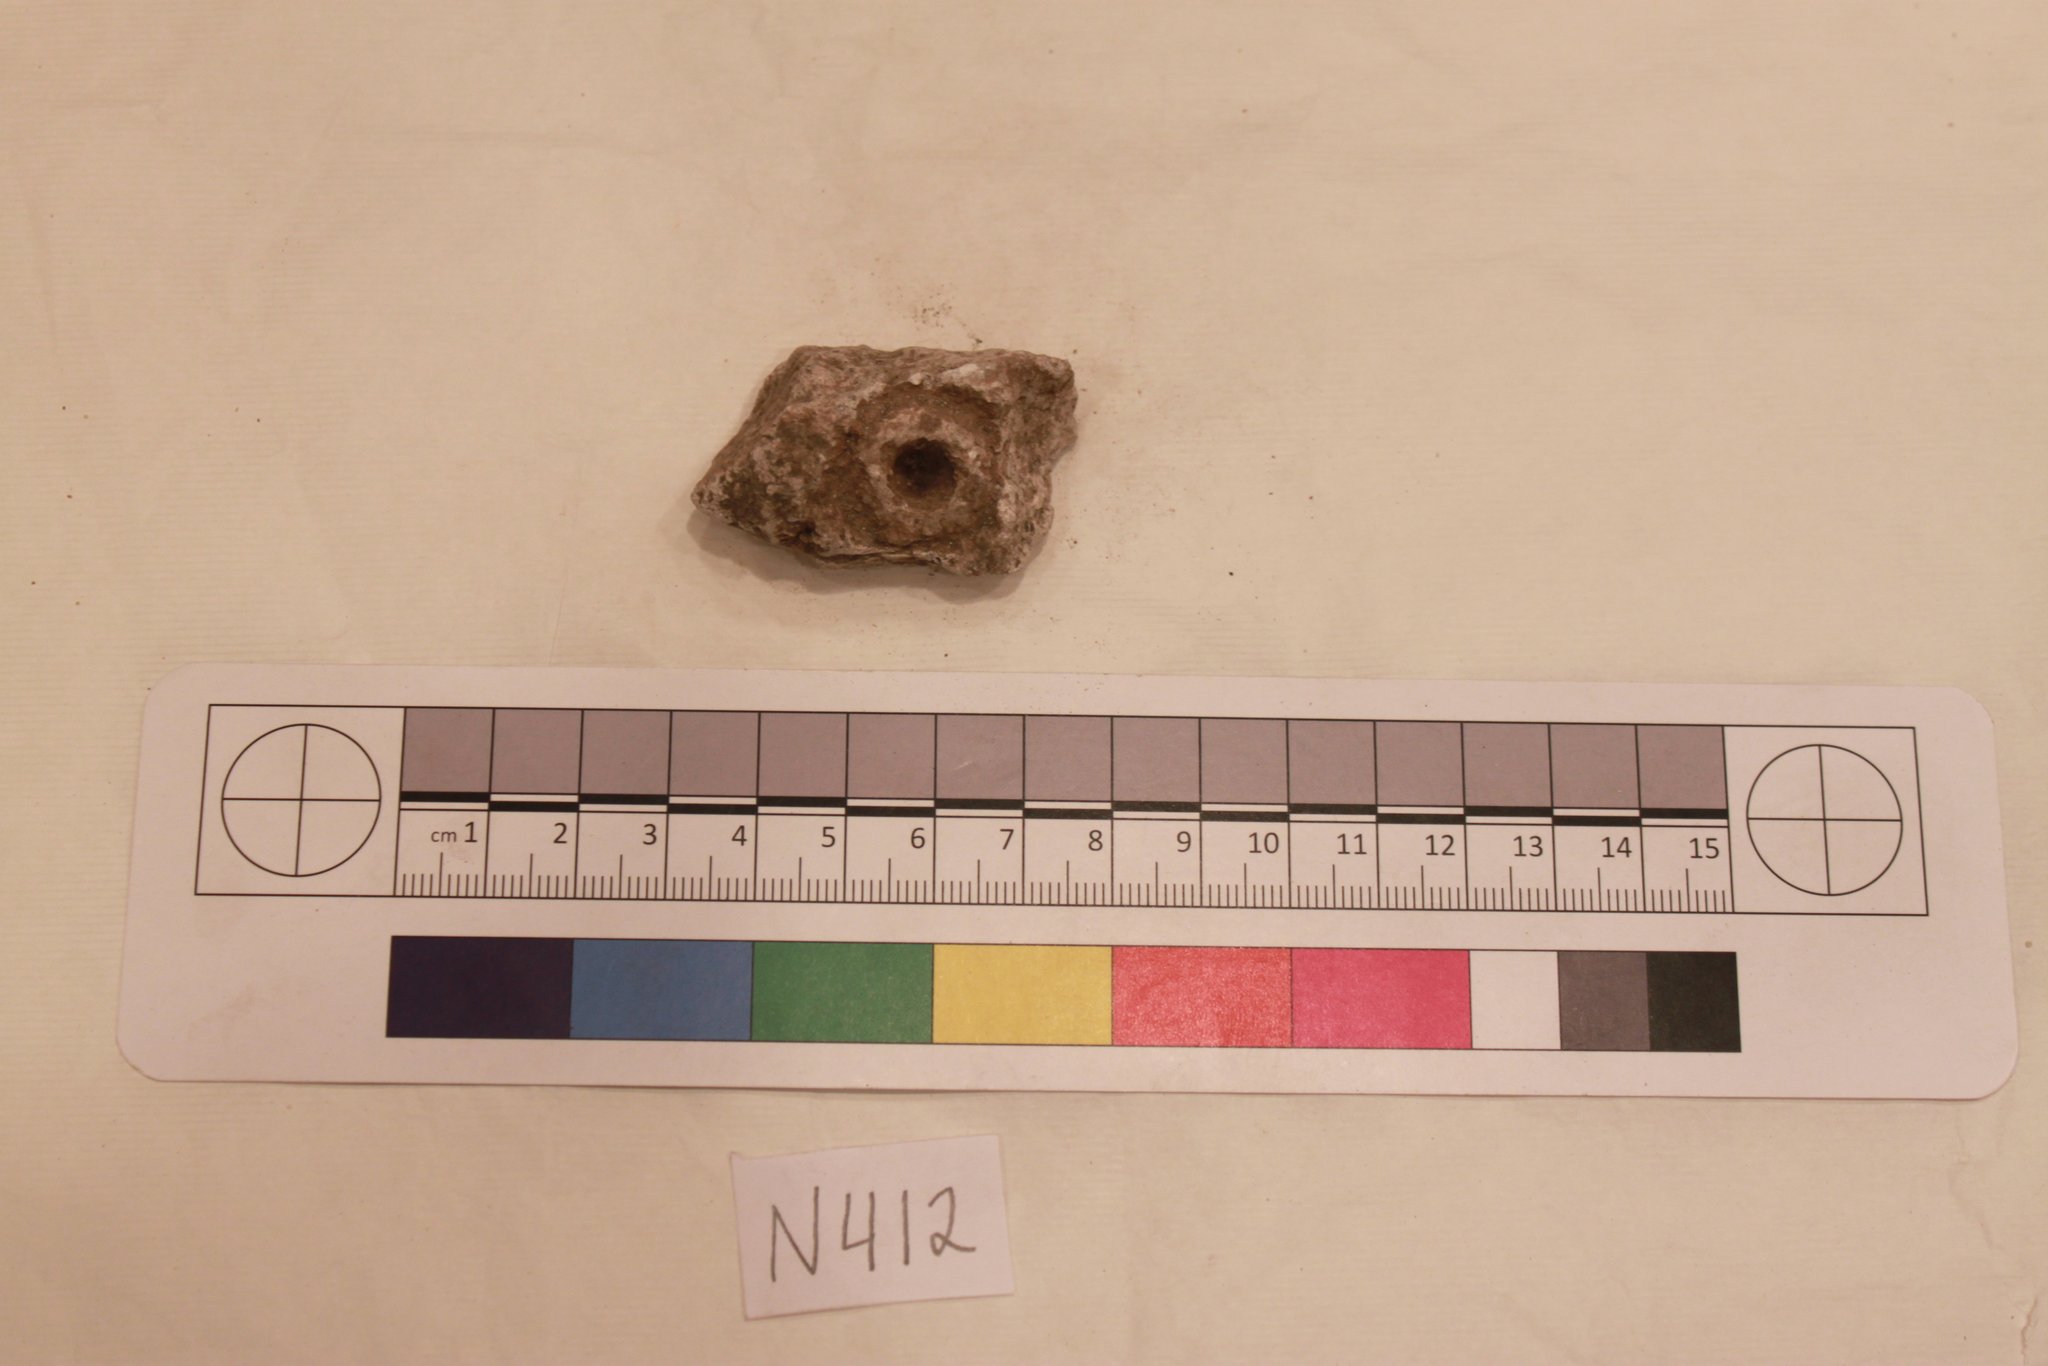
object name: fragment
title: Stucco Fragment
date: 701-1200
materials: plaster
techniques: carving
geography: iran